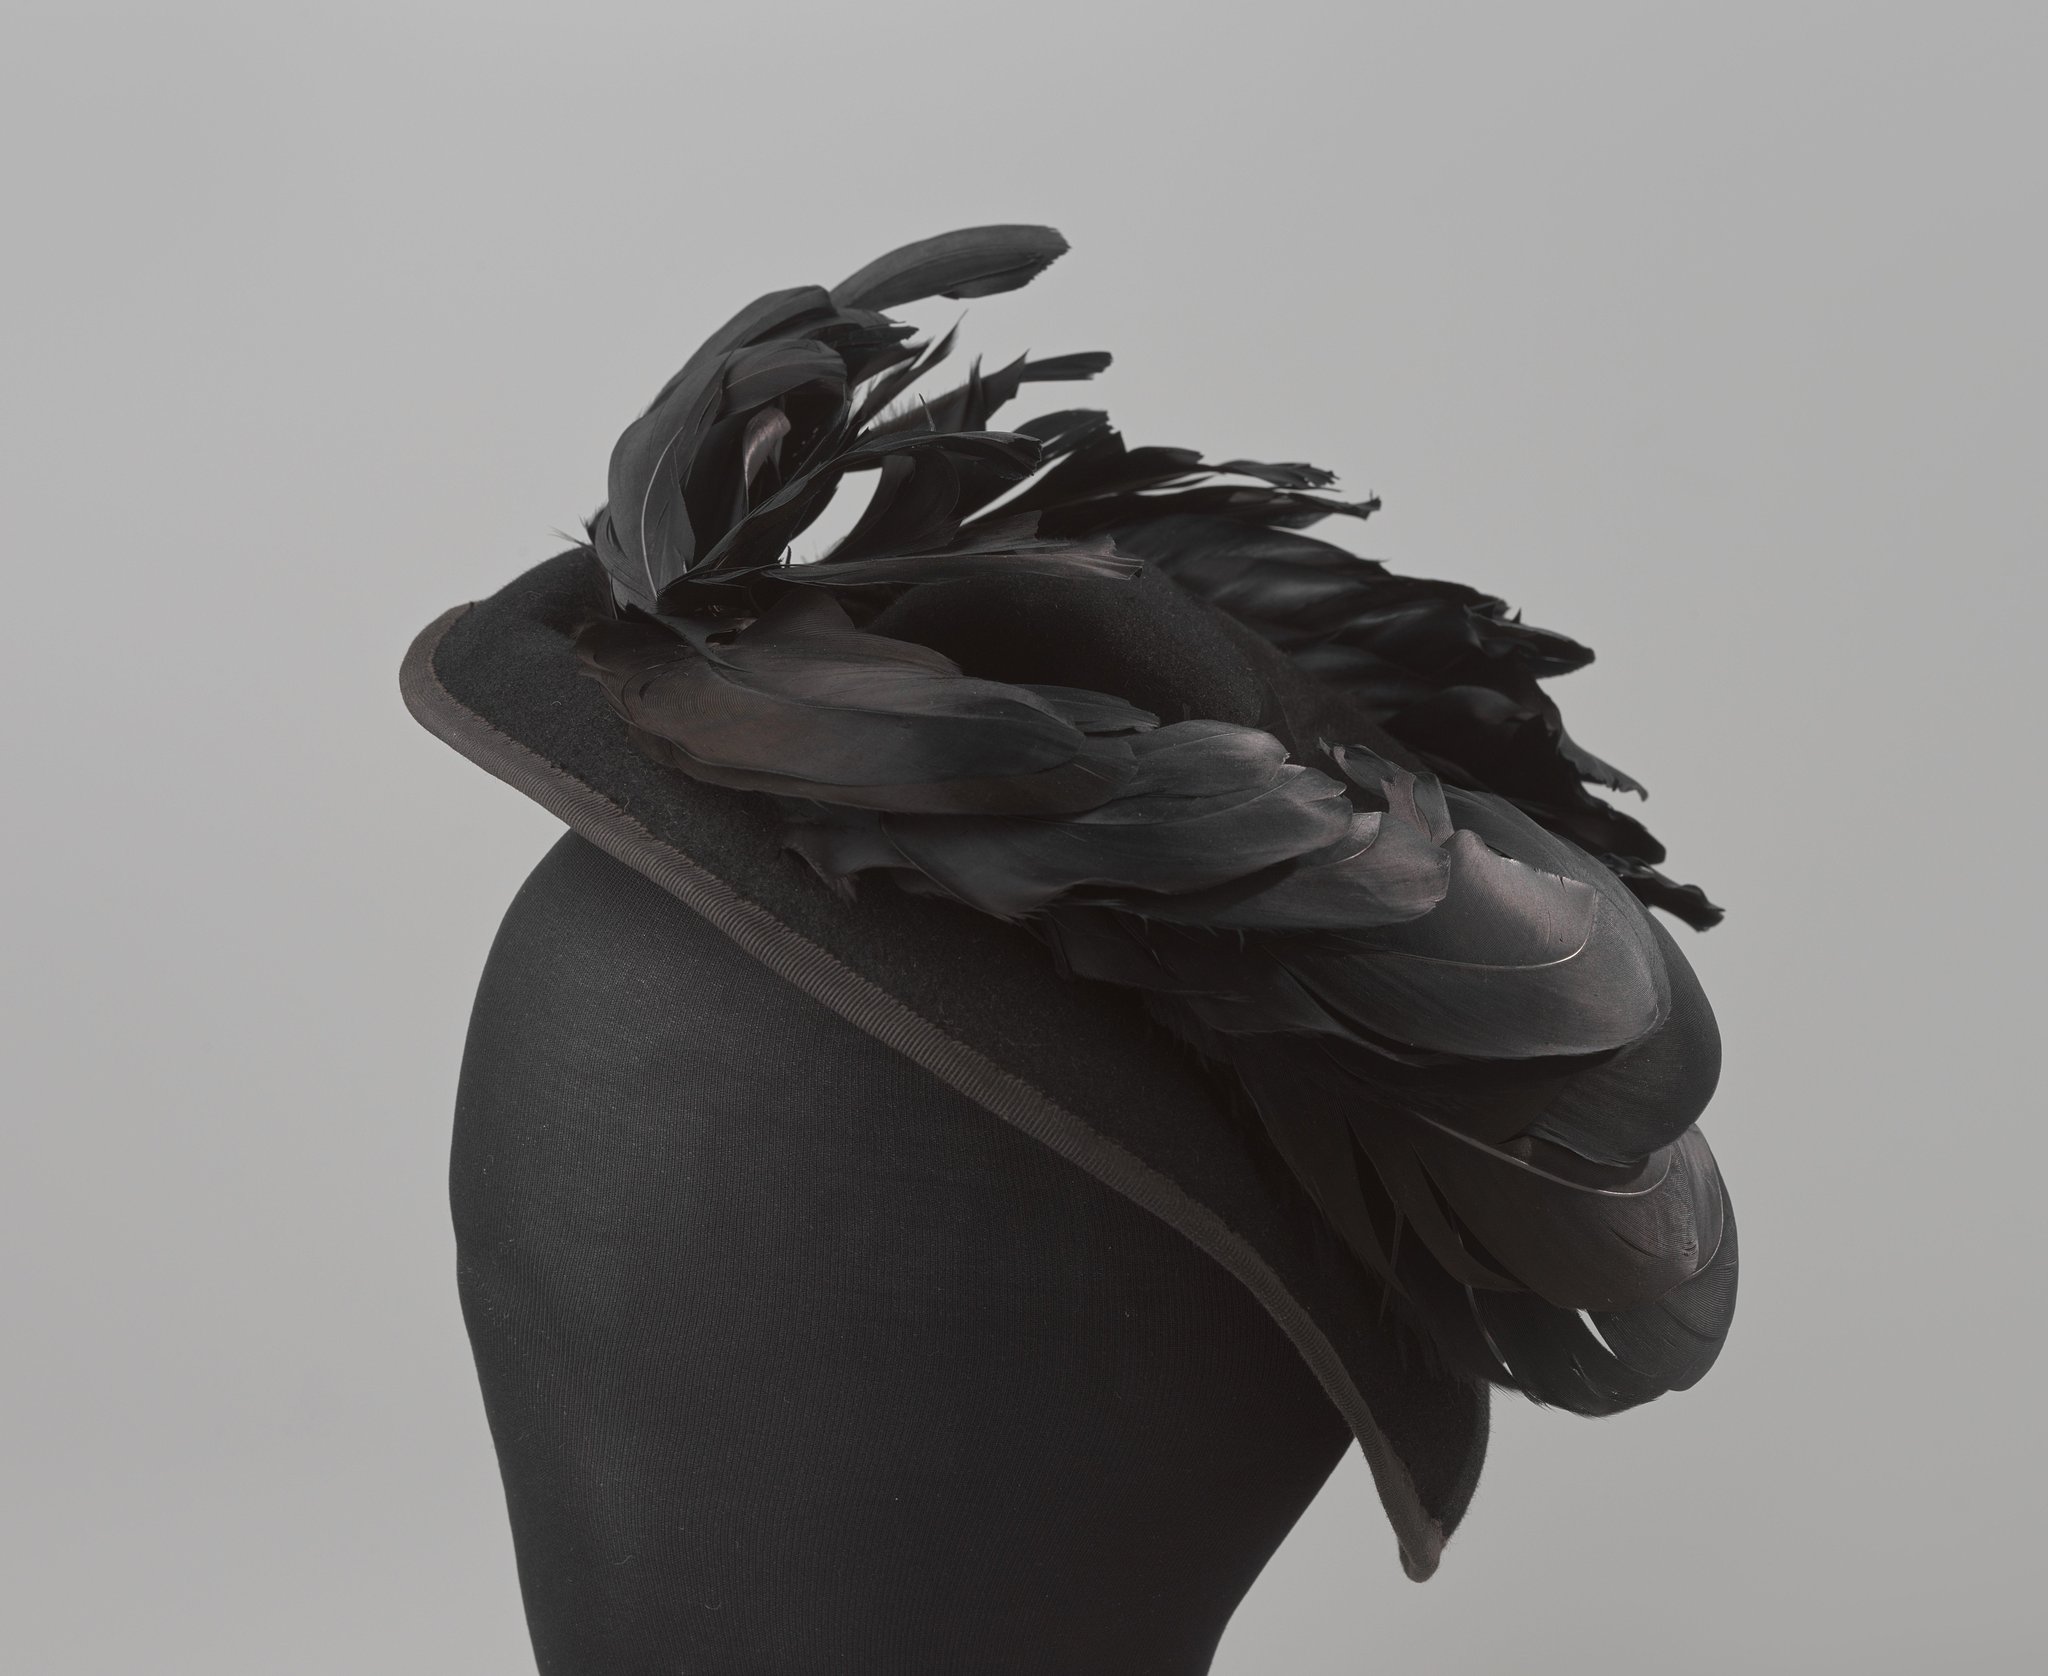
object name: womenswear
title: Hoed van zwart vilt met afhangende randen en zwarte veren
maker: Anonymous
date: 1850-1899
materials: feather, felt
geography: western europe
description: Hoed van zwart vilt met afhangende randen en zwarte veren. Model: vrij lage bol met ongelijke rand. Versiering met zwarte veren.